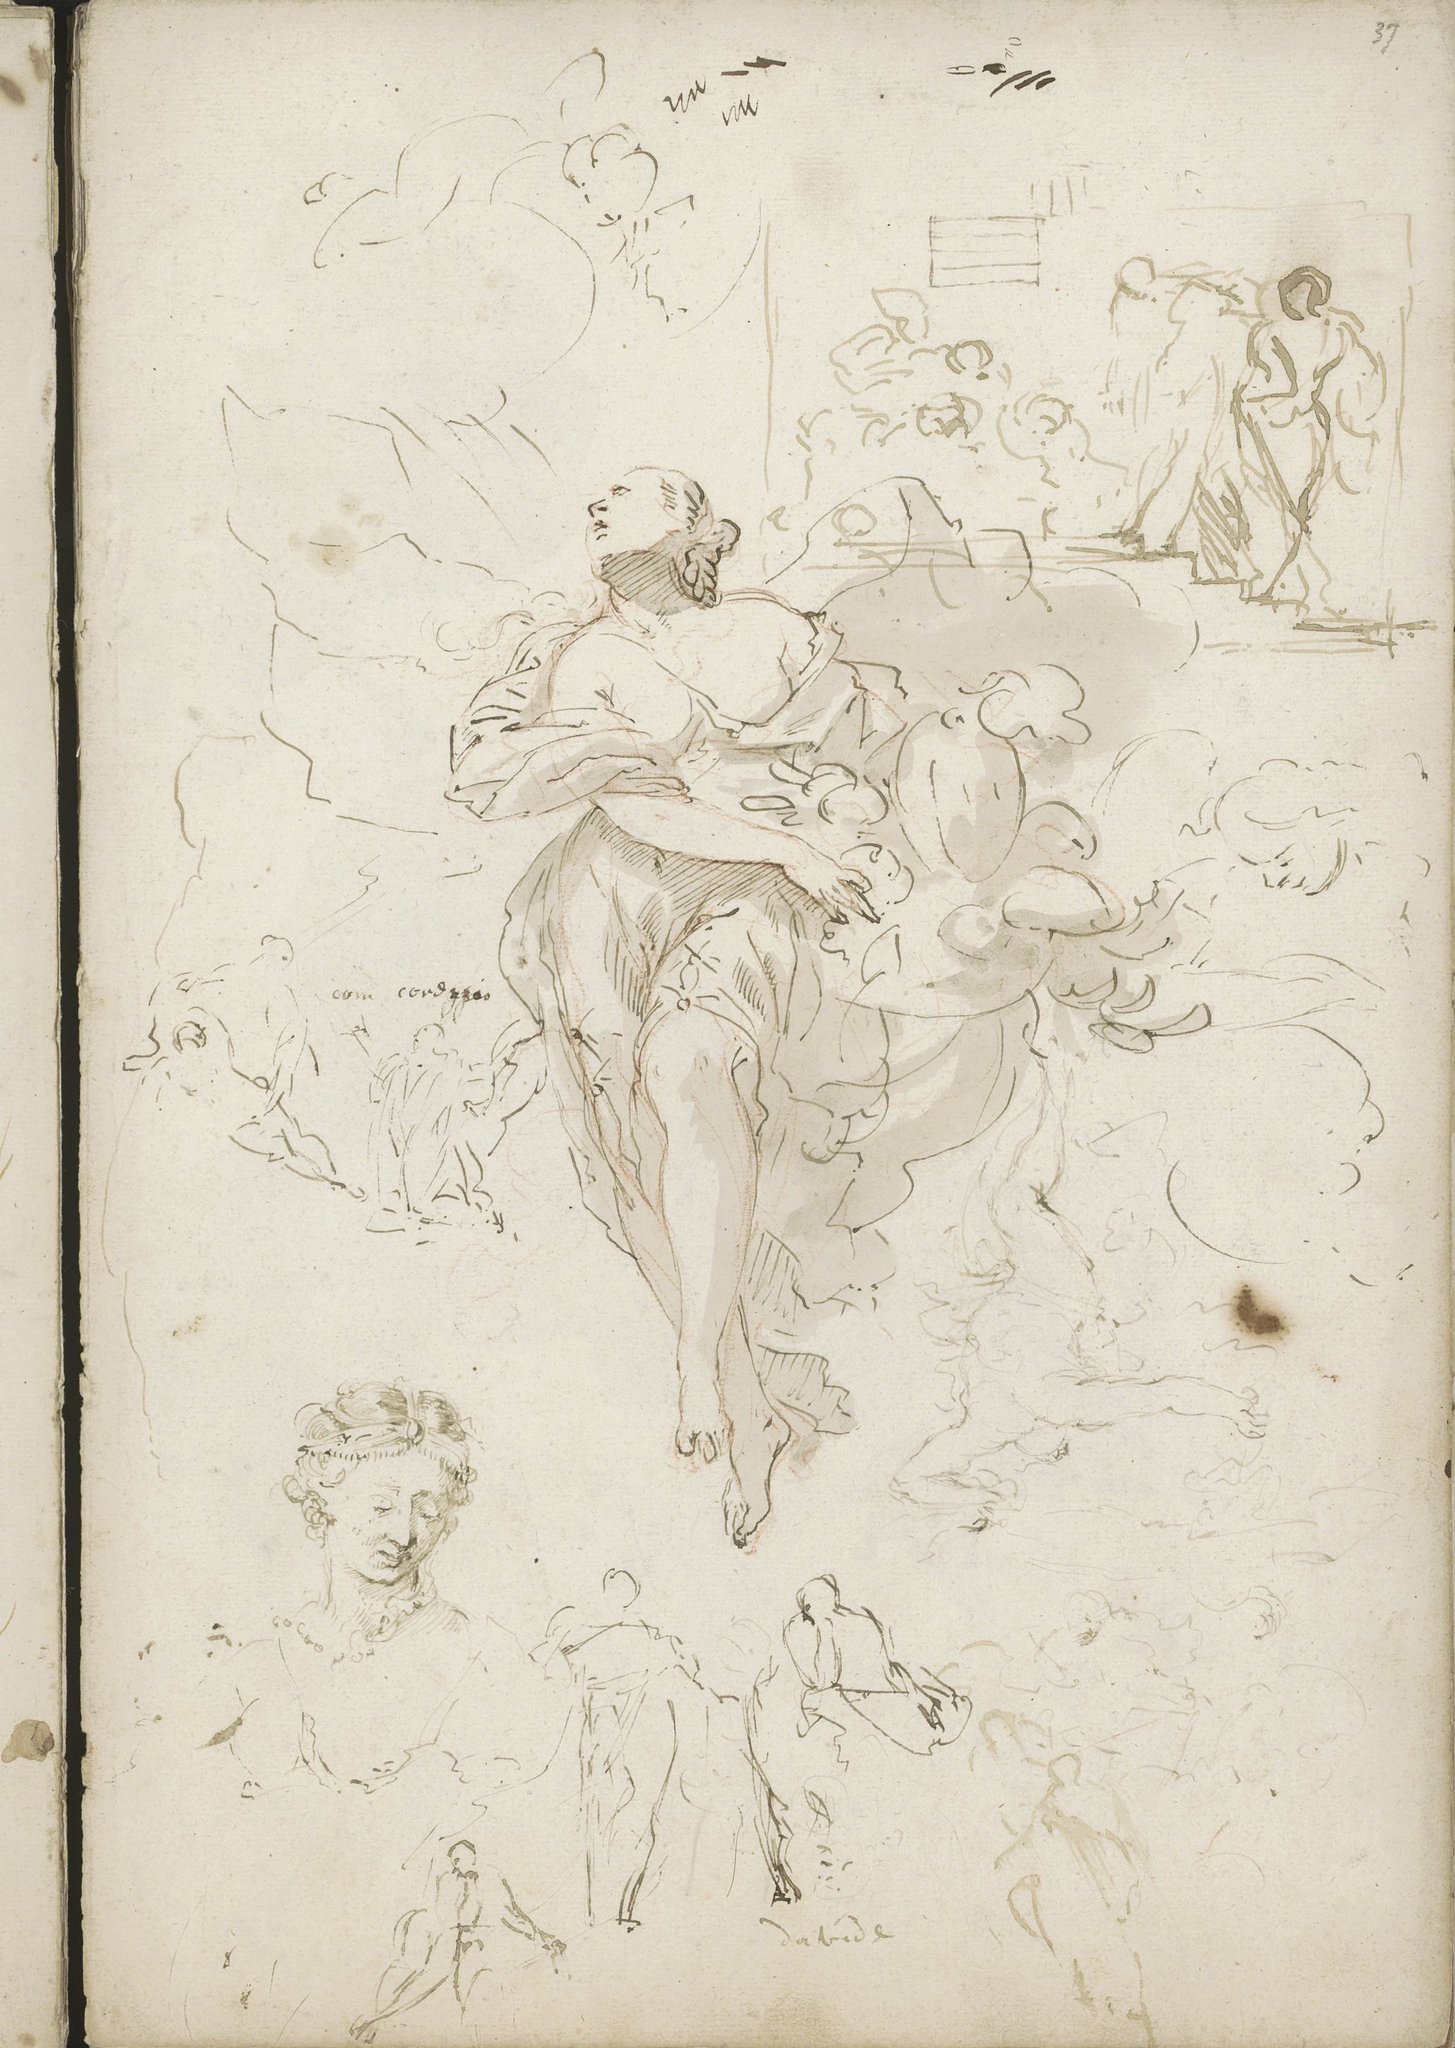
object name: sketchbook leaf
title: Studieblad, onder andere met een zwevende vrouw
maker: Anonymous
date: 1650-1799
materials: chalk, ink, paper, pencil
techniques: brush, pen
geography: italy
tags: head (human) - aa - female human figure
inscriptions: annotation: ‘com cond[...]is?/ da bide’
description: Tevens compositiestudies en een kop van een vrouw met haarversiering. Bladzijde 37 uit een schetsboek met 72 bladzijden.